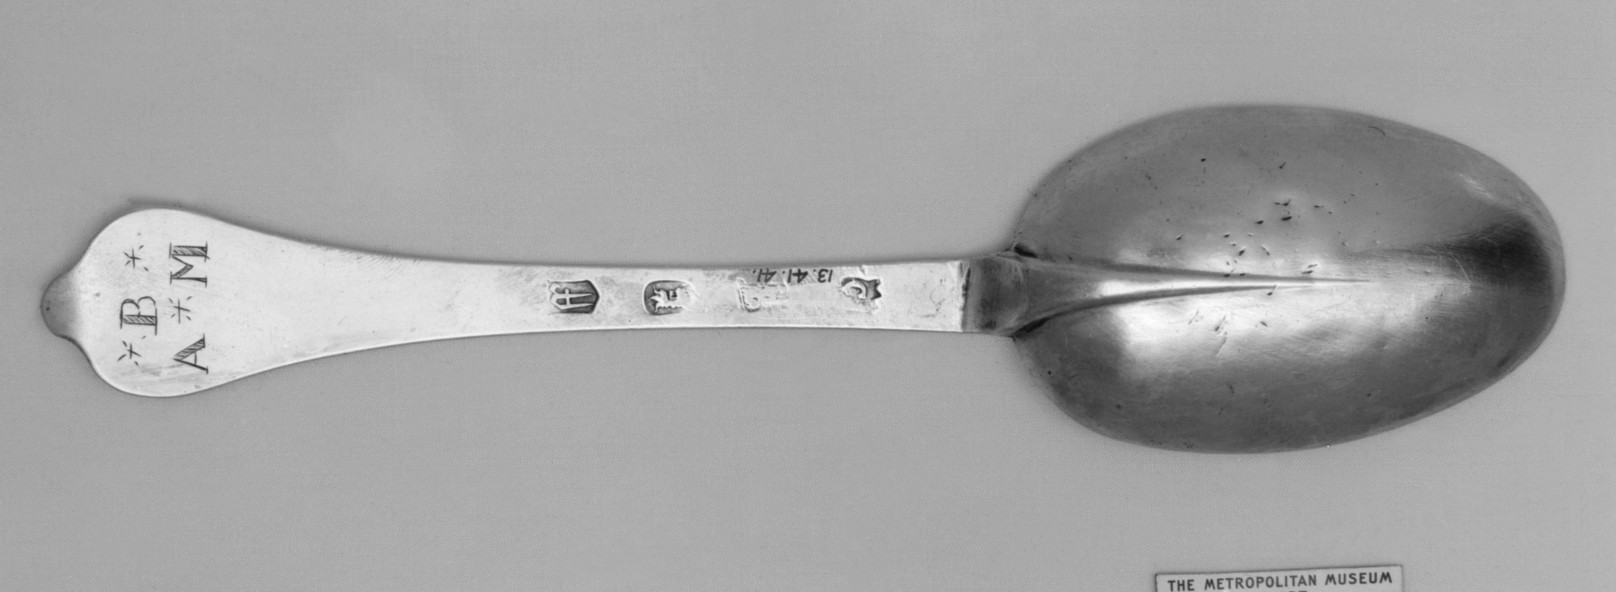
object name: spoon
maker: george cox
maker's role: maker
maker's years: 1698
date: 1701-1702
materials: silver